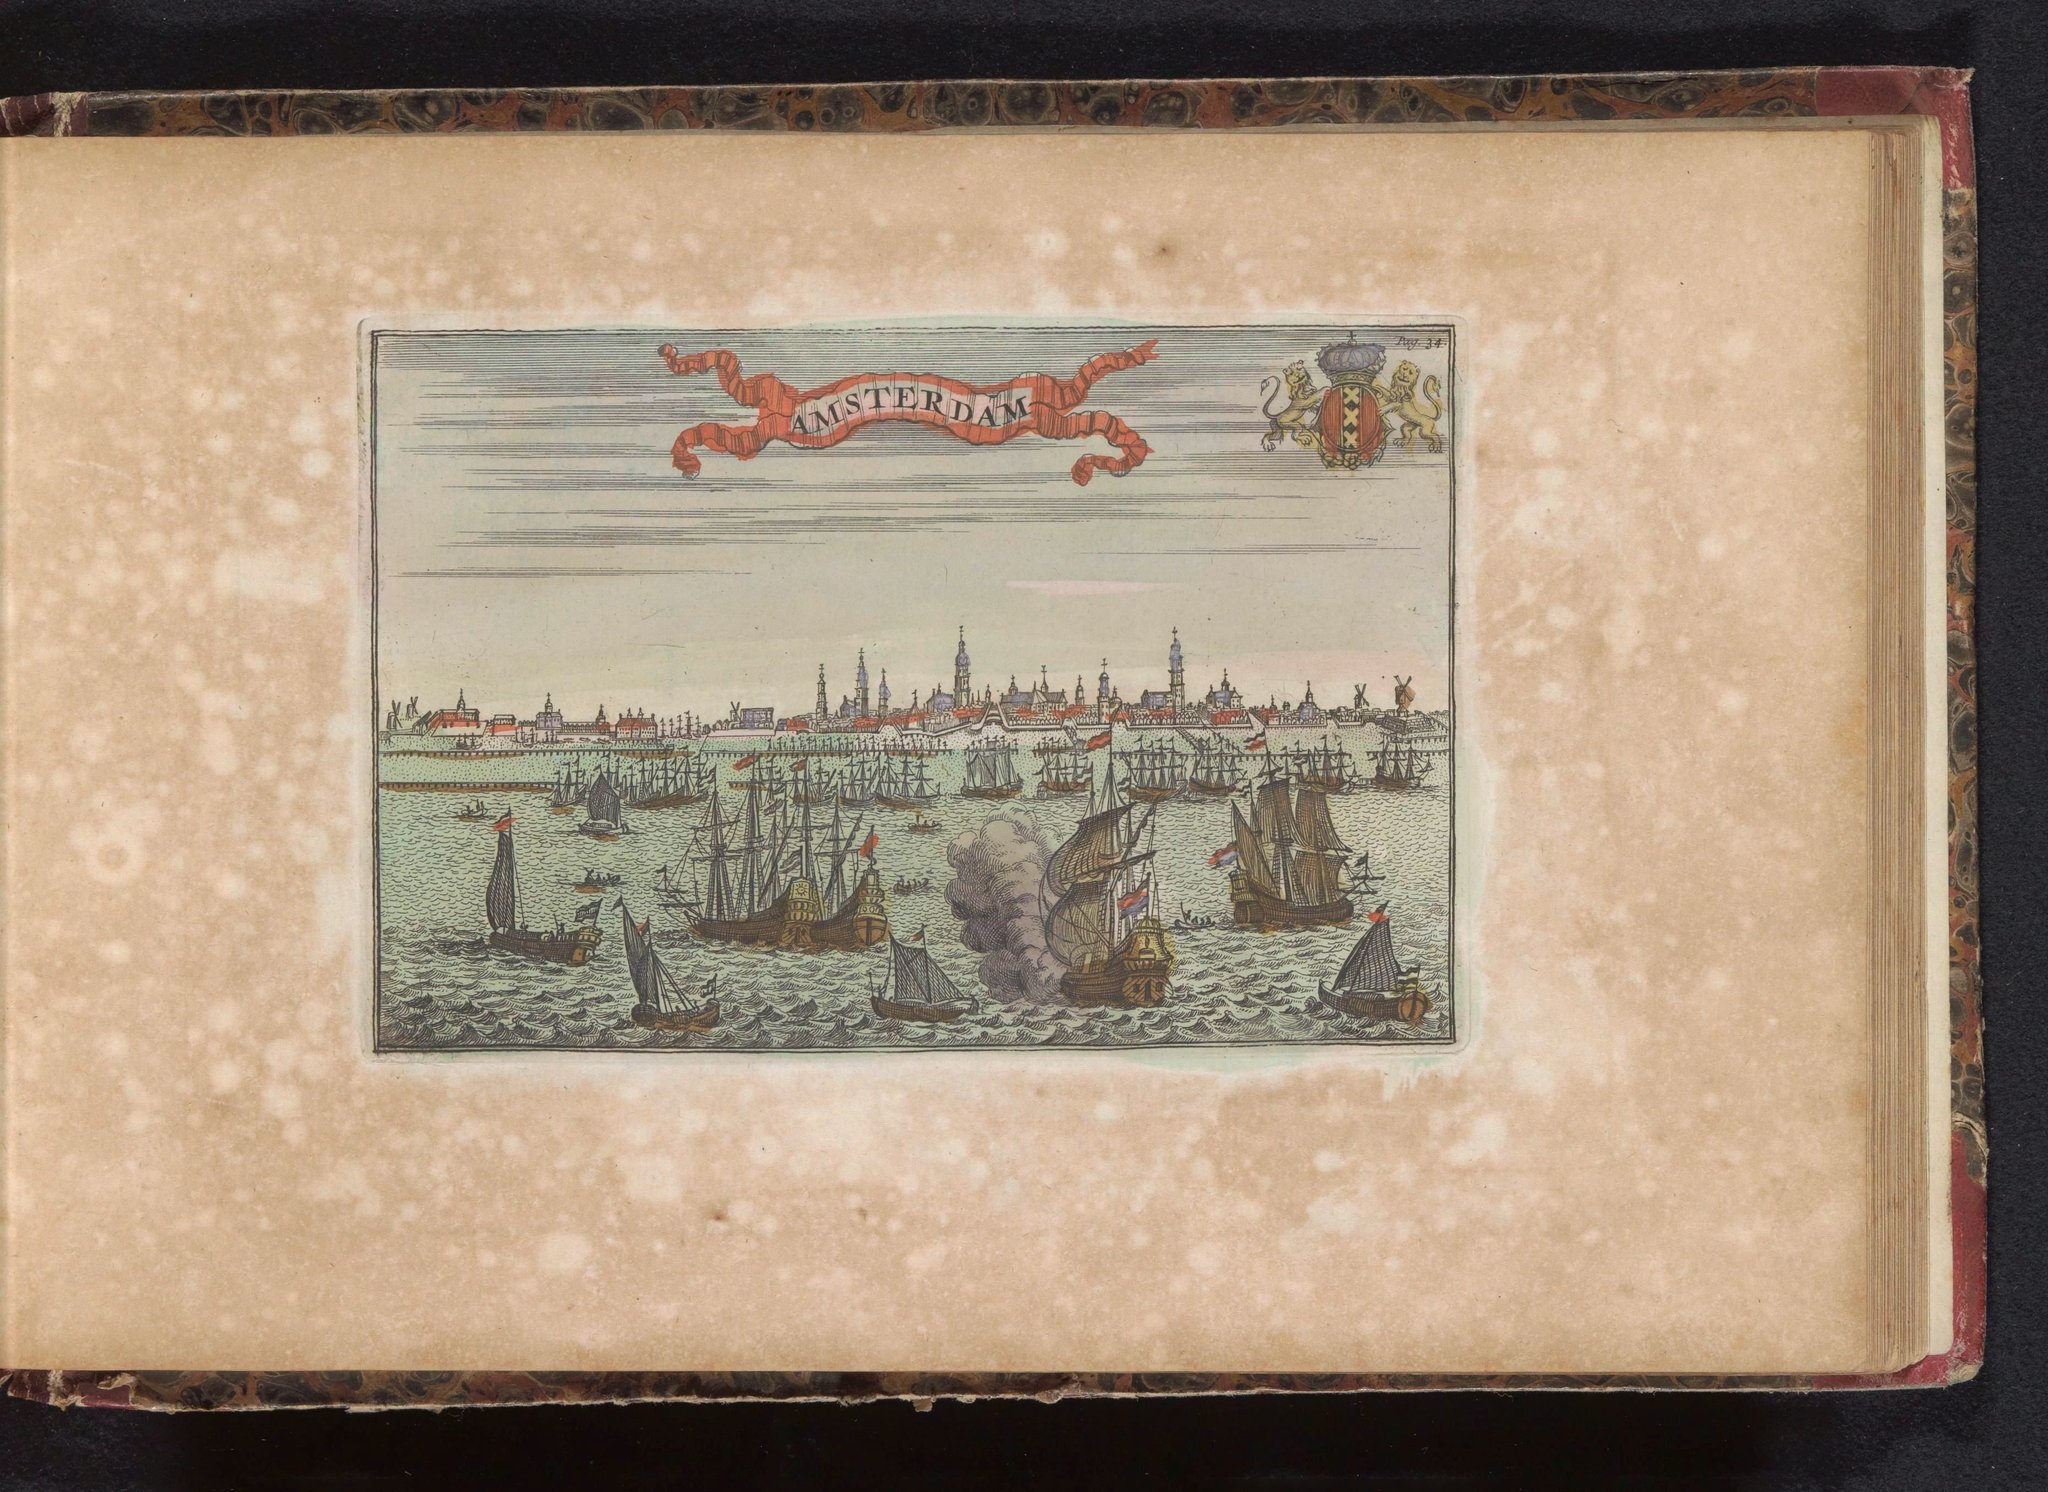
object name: print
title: Gezicht op Amsterdam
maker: Anonymous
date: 1735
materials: paper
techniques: engraving, etching, hand coloring, lacquer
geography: northern netherlands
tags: amsterdam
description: Gezicht op Amsterdam, op de voorgrond schepen op het IJ. Onderdeel van een atlas met 223 kaarten van landen en steden en oorlogstaferelen in Europa in de periode ca. 1690-1735.